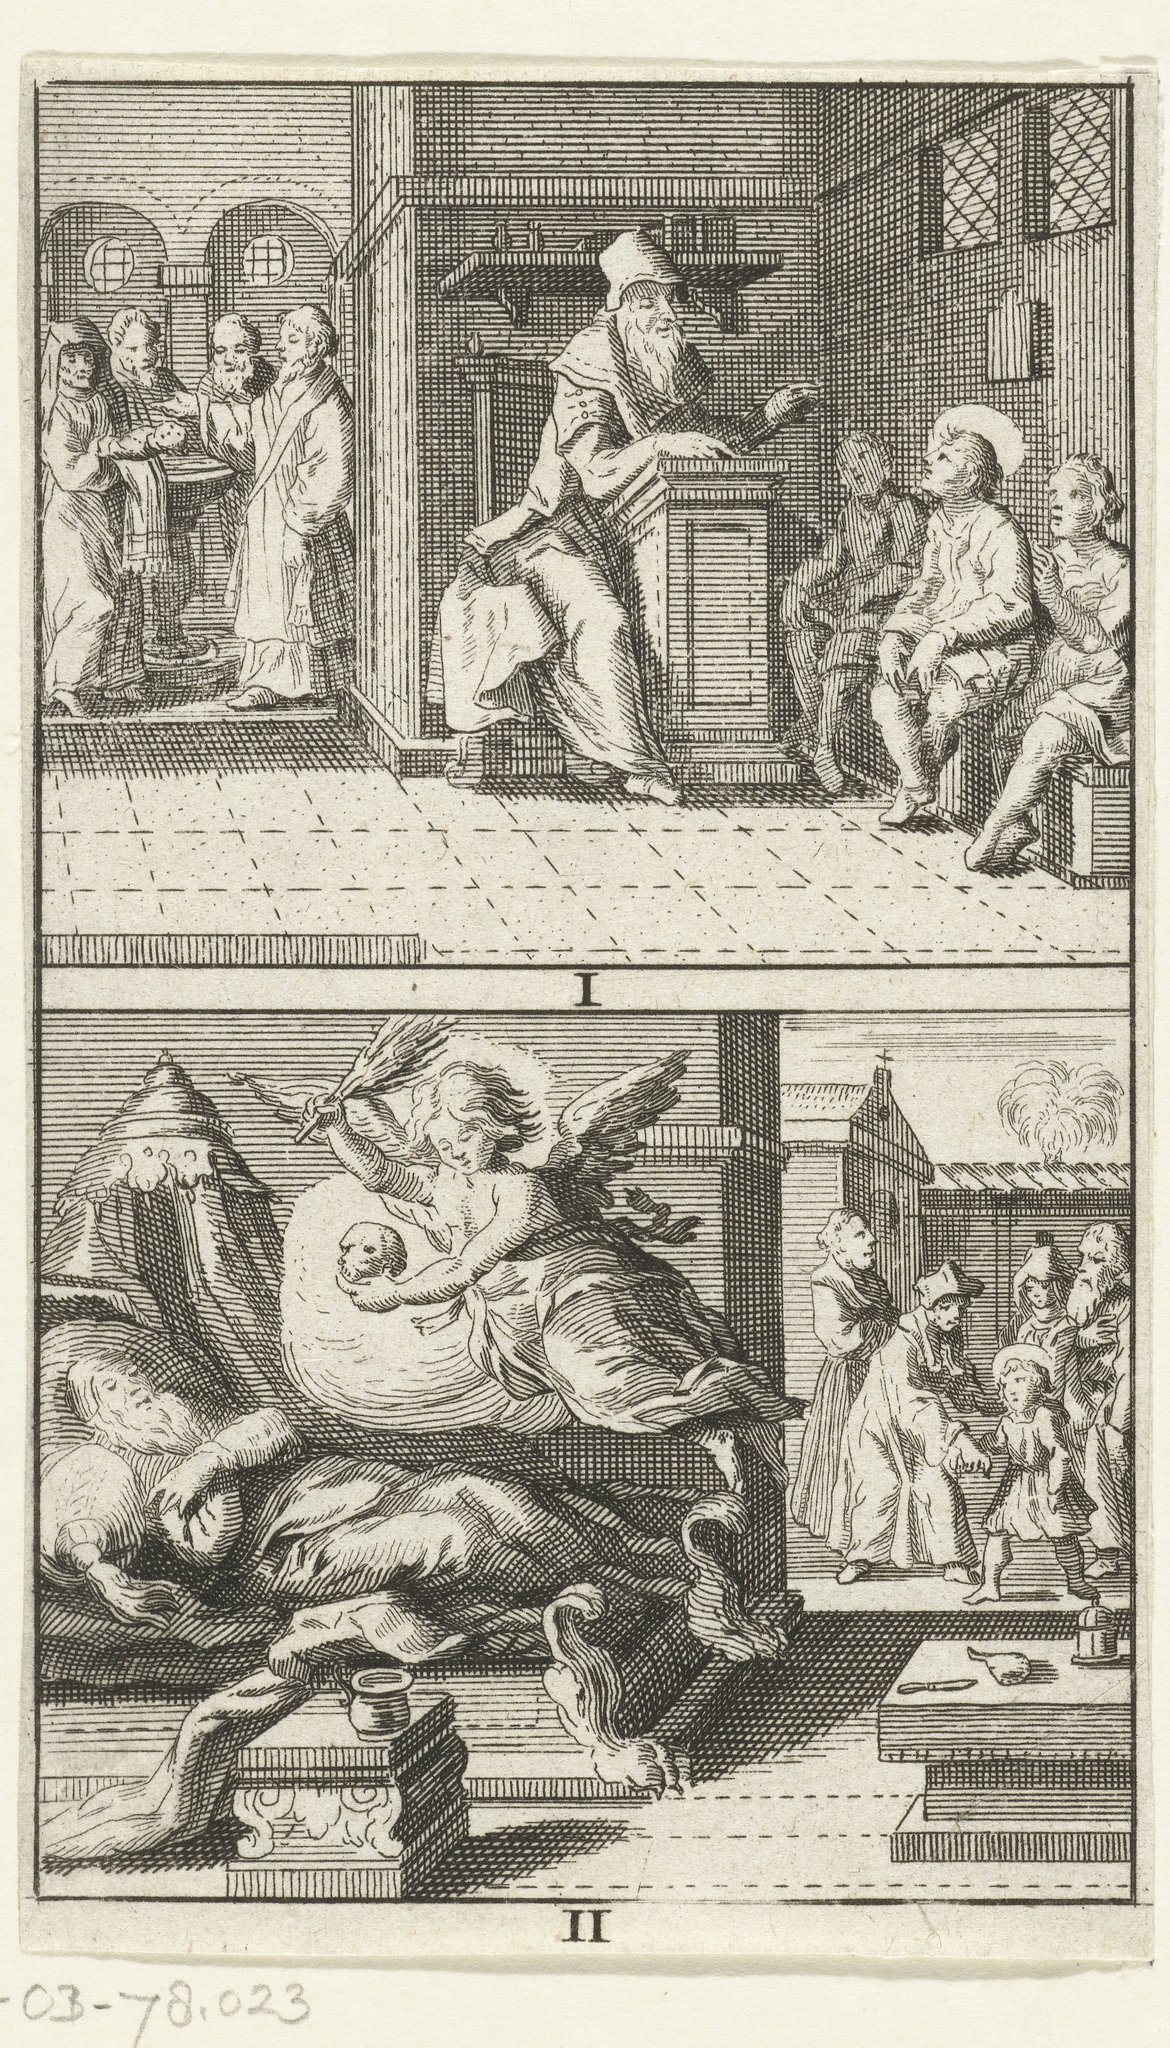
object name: print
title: Scènes uit het leven van de heilige Bonifatius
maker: Anonymous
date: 1640-1659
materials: paper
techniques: etching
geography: low countries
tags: the martyr boniface, 'apostle of germany', and archbishop of mainz; possible attributes: axe in root of tree, book pierced by a sword, fountain (springing up from under his staff), whip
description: Scènes uit het leven van de heilige Bonifatius, platen I en II. Episoden uit zijn jeugd. Tweede prent in een serie prenten over het leven van de heilige Bonifatius, bestaande uit een grote afbeelding van de heilige gevolgd door 8 platen met telkens twee kleinere genummerde voorstellingen onder elkaar.